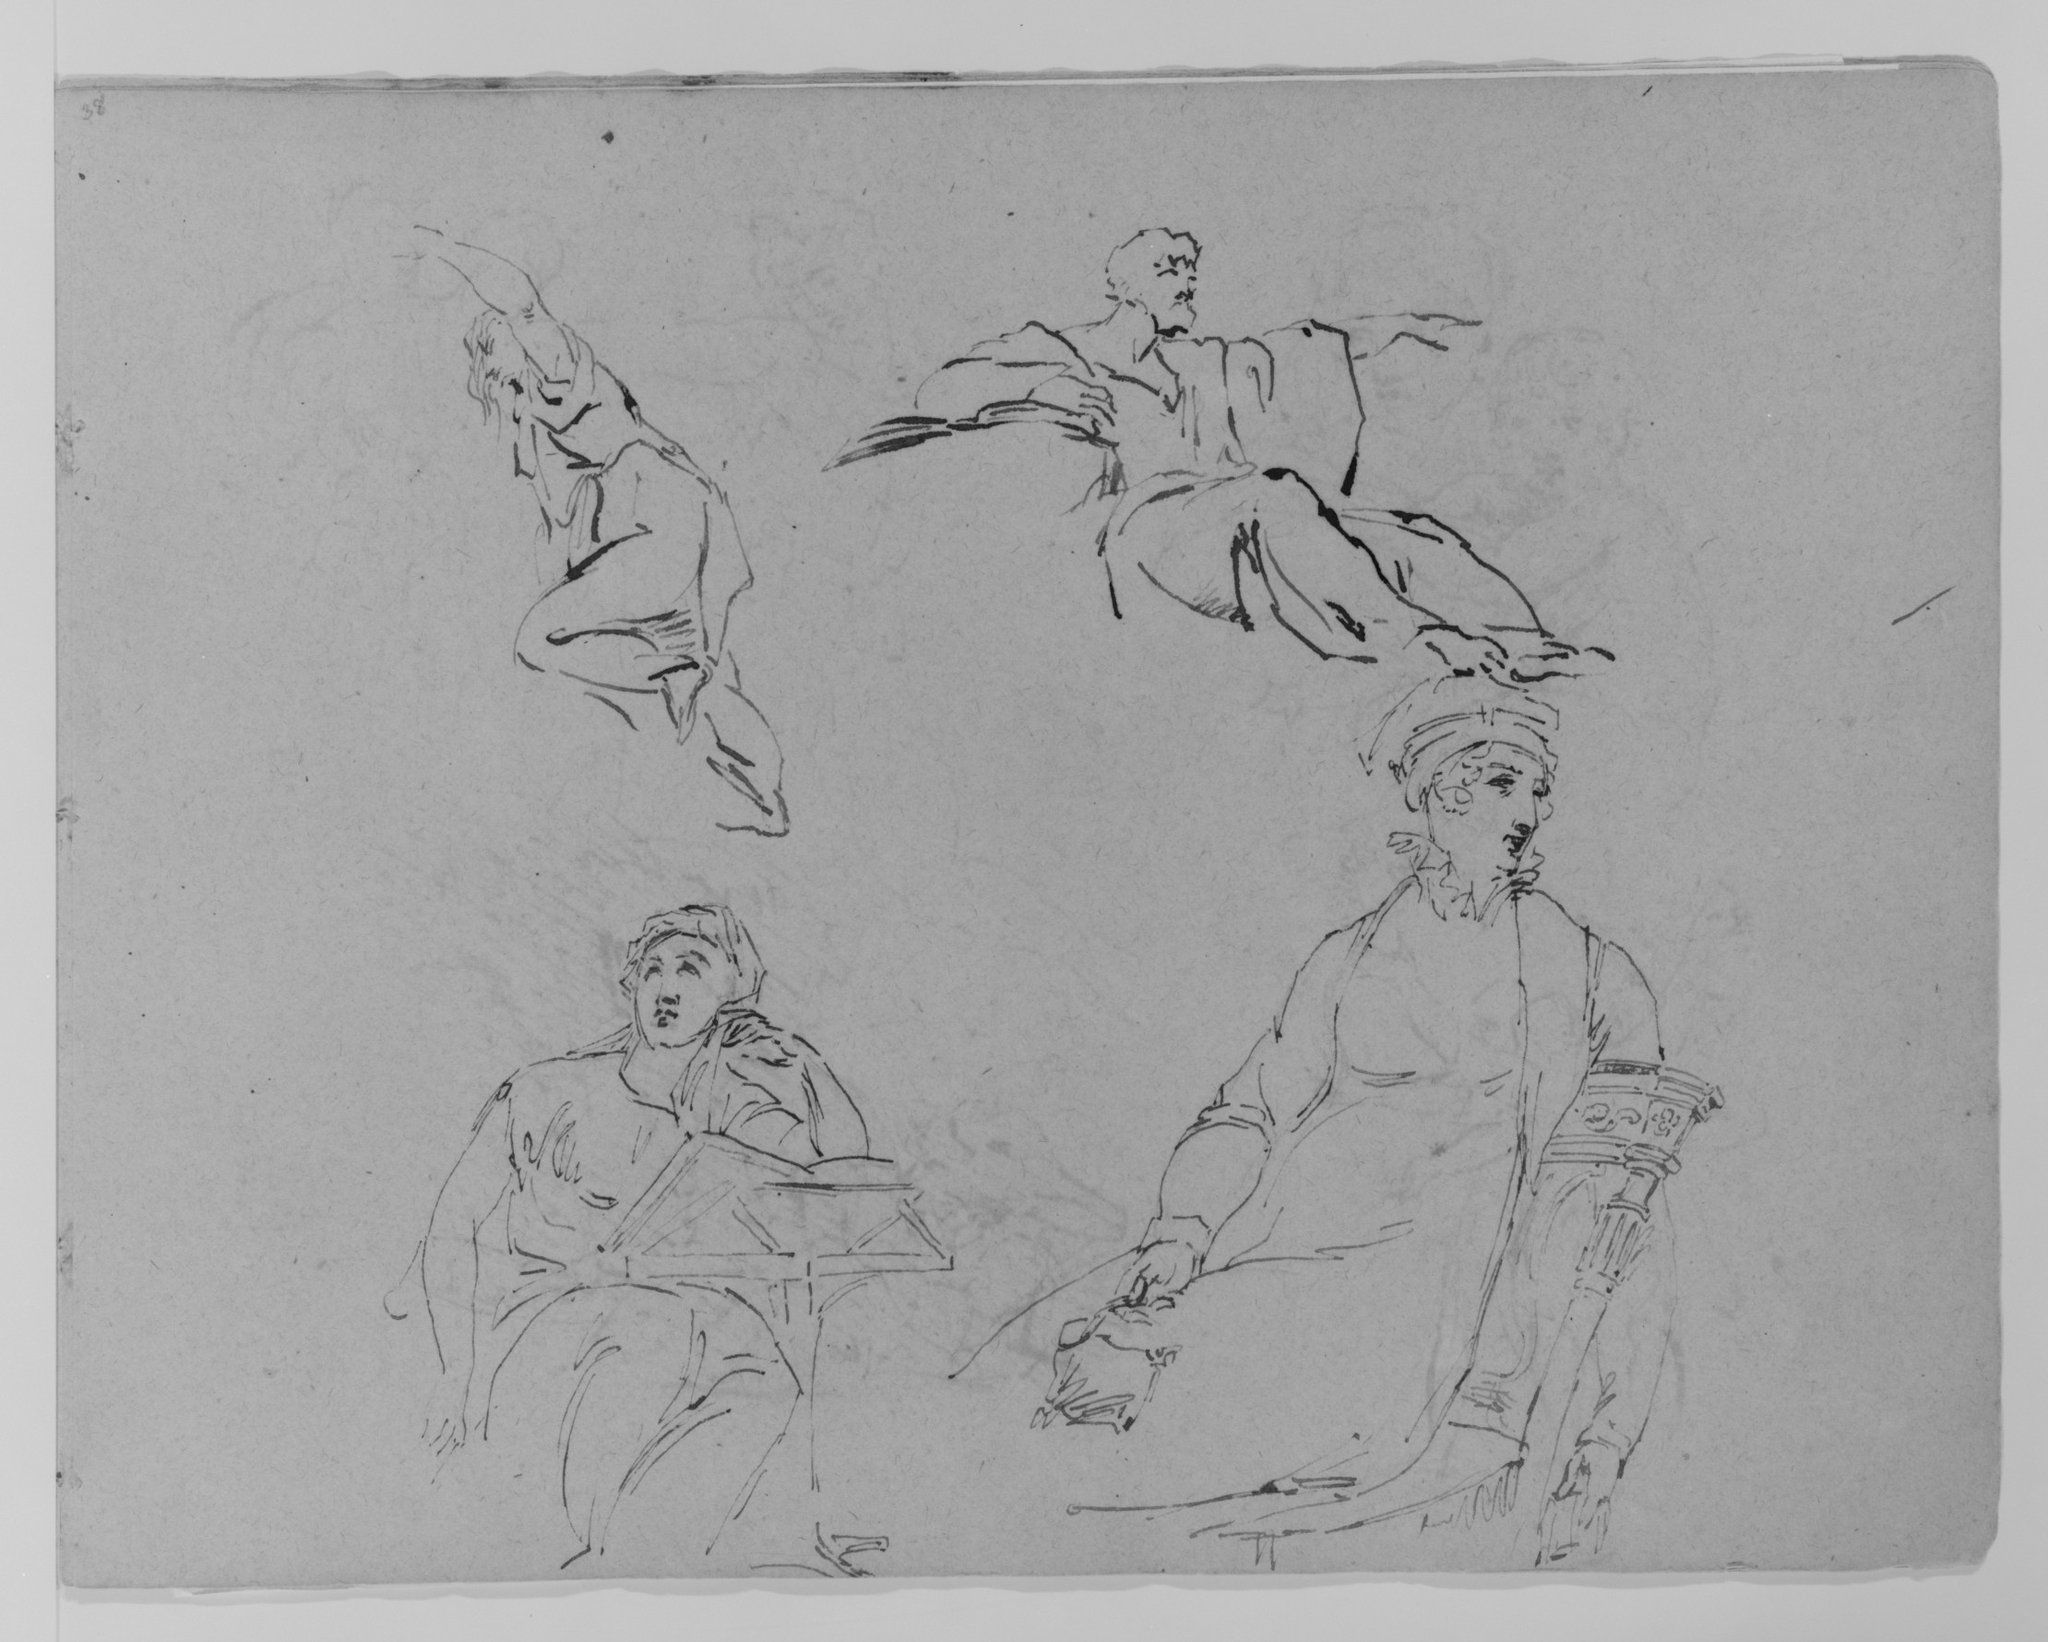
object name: drawing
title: Four Figure Studies (from Sketchbook)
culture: american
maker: thomas sully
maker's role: artist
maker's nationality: american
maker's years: 1783-1872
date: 1810-1820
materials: ink, paper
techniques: wash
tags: men,women